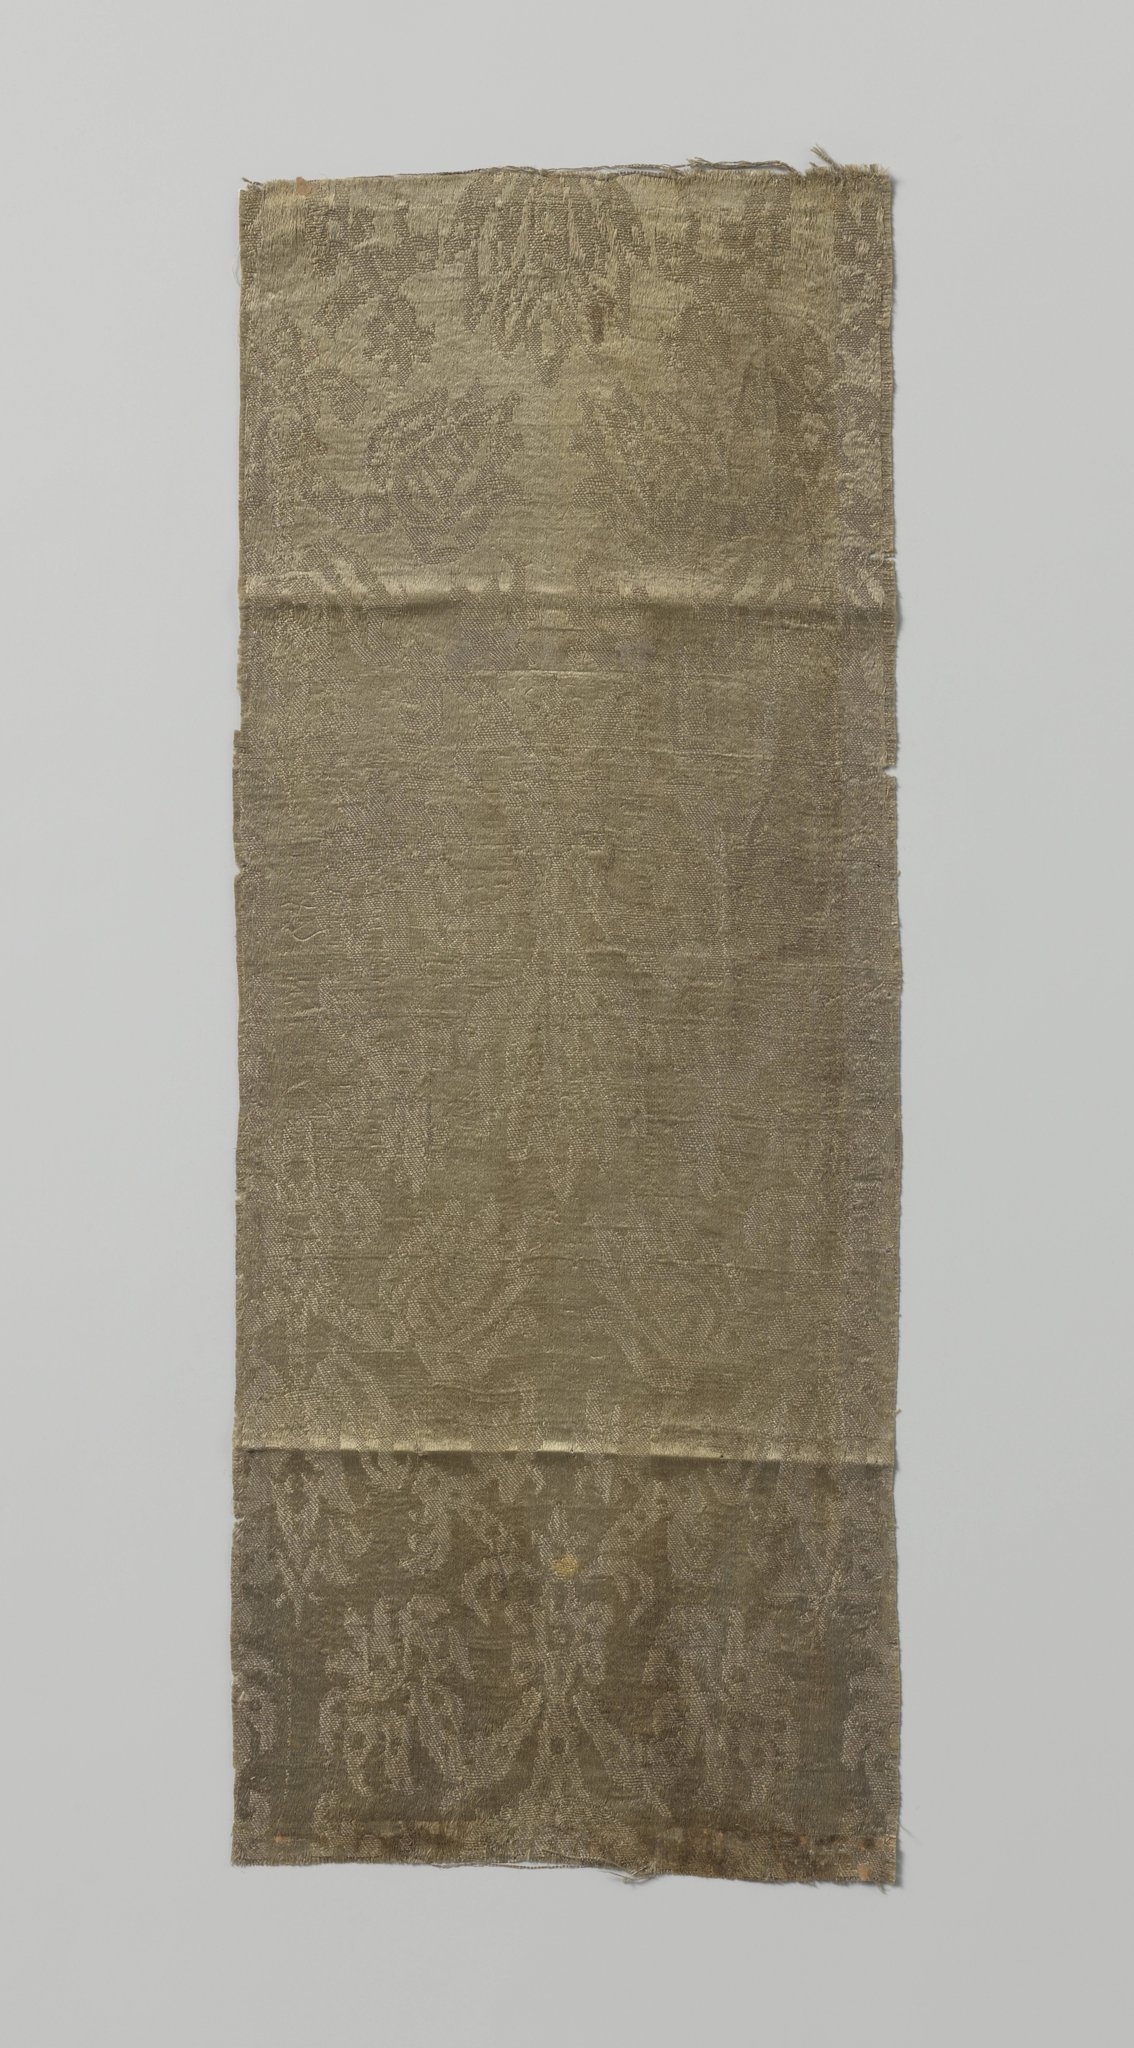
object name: zijdedamast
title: Fragment zijdeweefsel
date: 1600-1610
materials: silk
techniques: damask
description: Fragment grijze damast met patroon van gestileerde tulpen en andere bloemen.